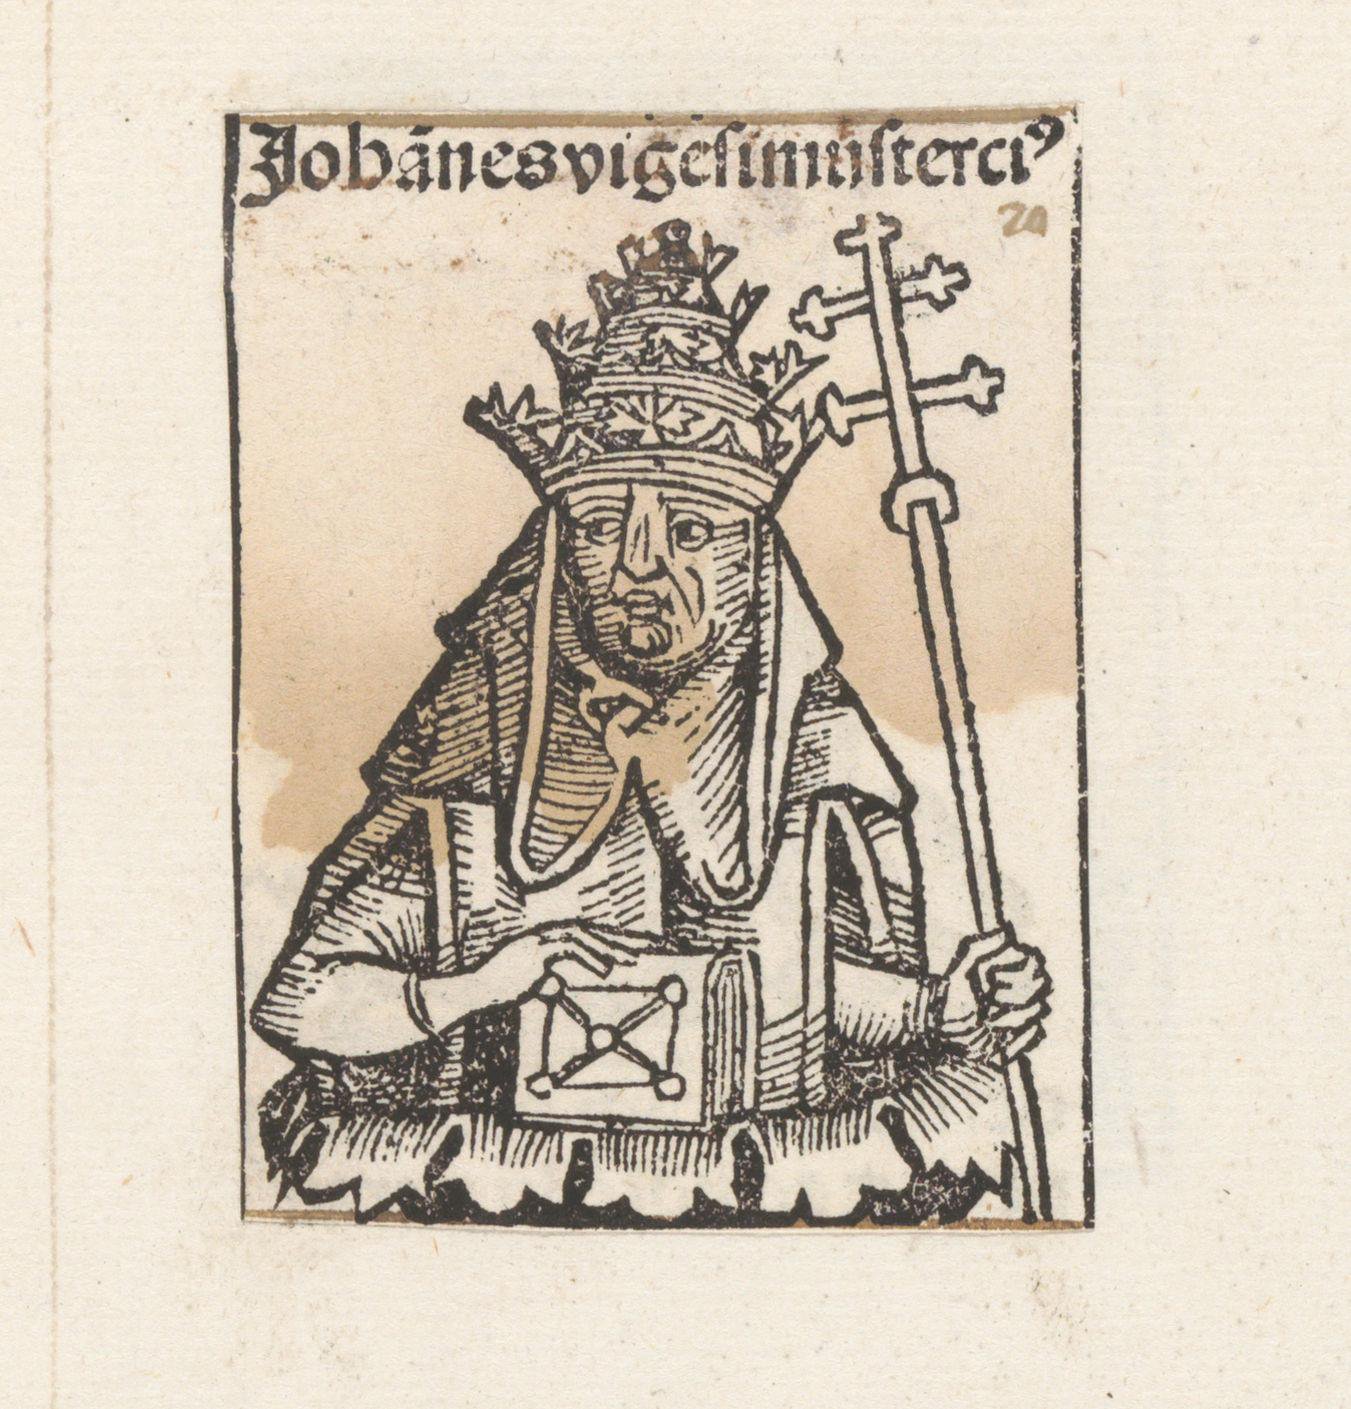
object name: album leaf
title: Liber Chronicarum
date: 1493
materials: paper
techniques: letterpress printing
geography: nuremberg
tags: clergyman, pope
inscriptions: inscription: ‘24’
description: Een bloemkelk met een paus. Hij draagt een tiara en heeft een bijbel en een staf met een dubbel kruis in zijn handen. De voorstelling is onderdeel van de opeenvolging pausen in de Liber Chronicarum. De tekst identificeert de man als tegenpaus Johannes XXIII. De prent maakt deel uit van een album.